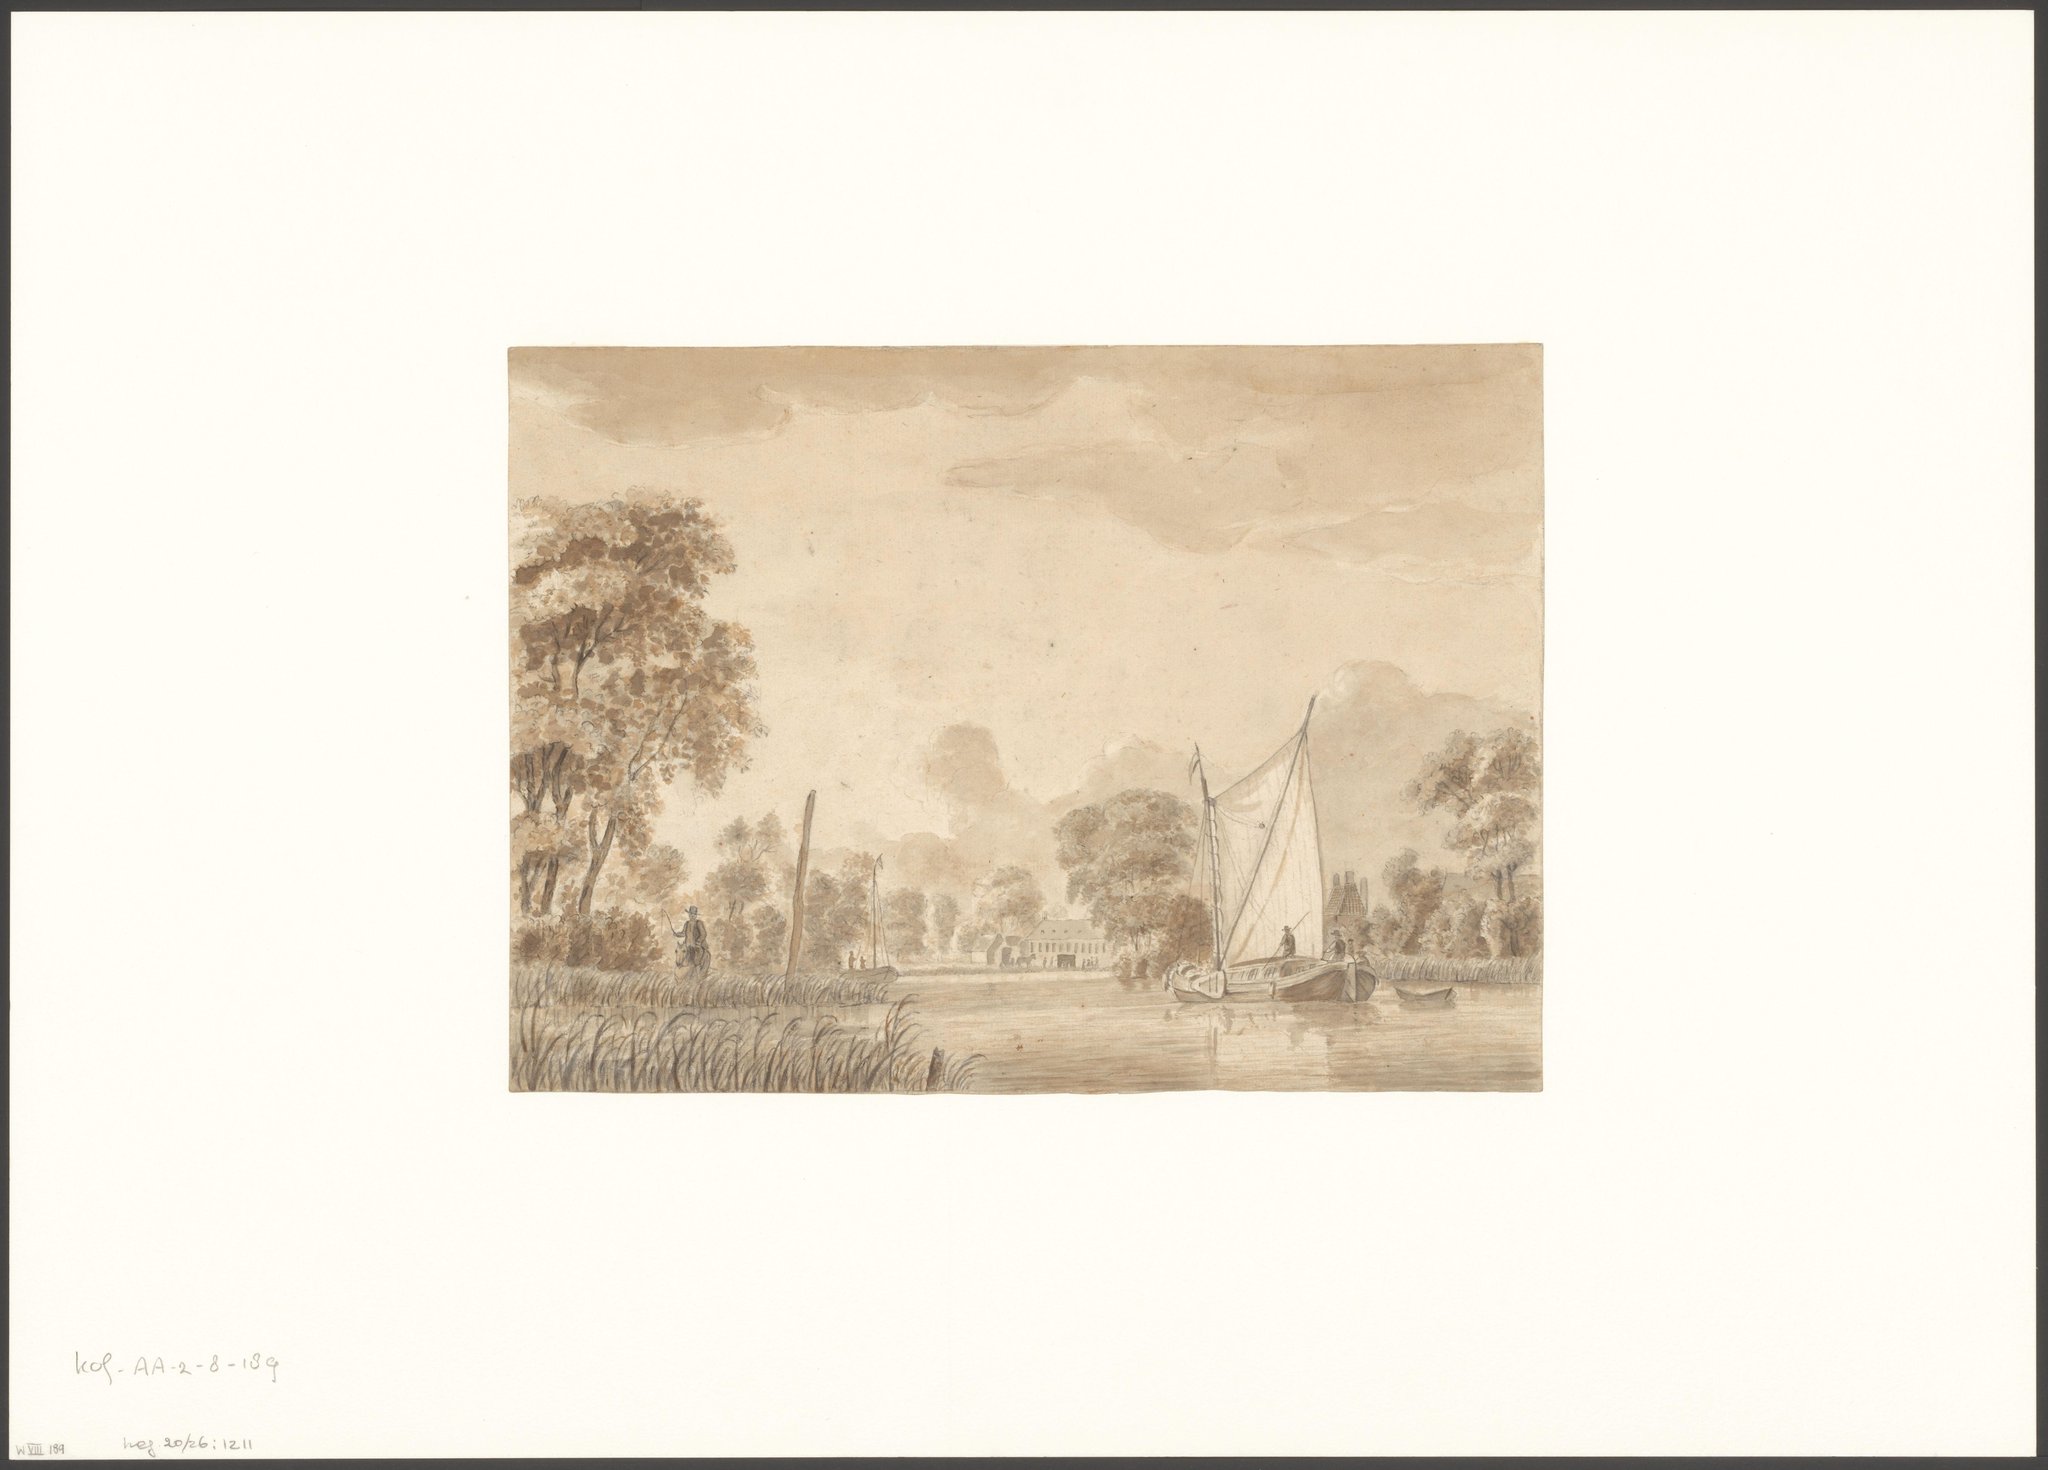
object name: drawing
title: Gezicht op herberg Het Kalfje aan de Amsteldijk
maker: Anonymous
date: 1701-1769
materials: chalk, ink, paper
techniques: brush, pen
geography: amsterdam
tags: city-view in general; 'veduta', canal, hotel, hostelry, inn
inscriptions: date: ‘January 1769’, inscription: ‘gezigt van 't Kalfje aan den Amstel’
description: Tekening binnen de Atlas Van Eck ingedeeld op wijknummer 8.